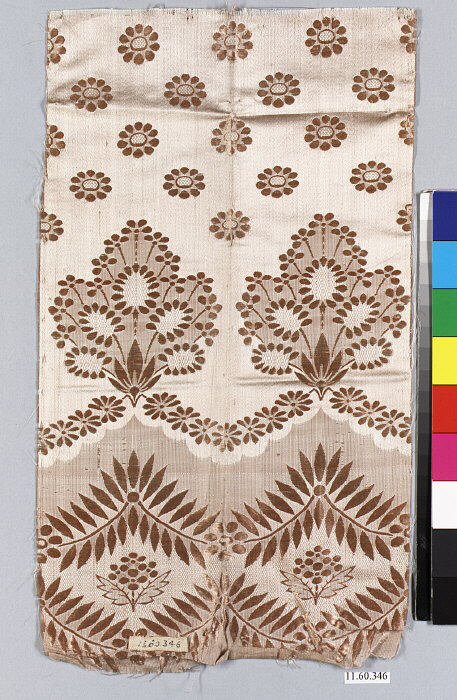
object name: fragment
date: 1801-1900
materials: silk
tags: flowers,leaves